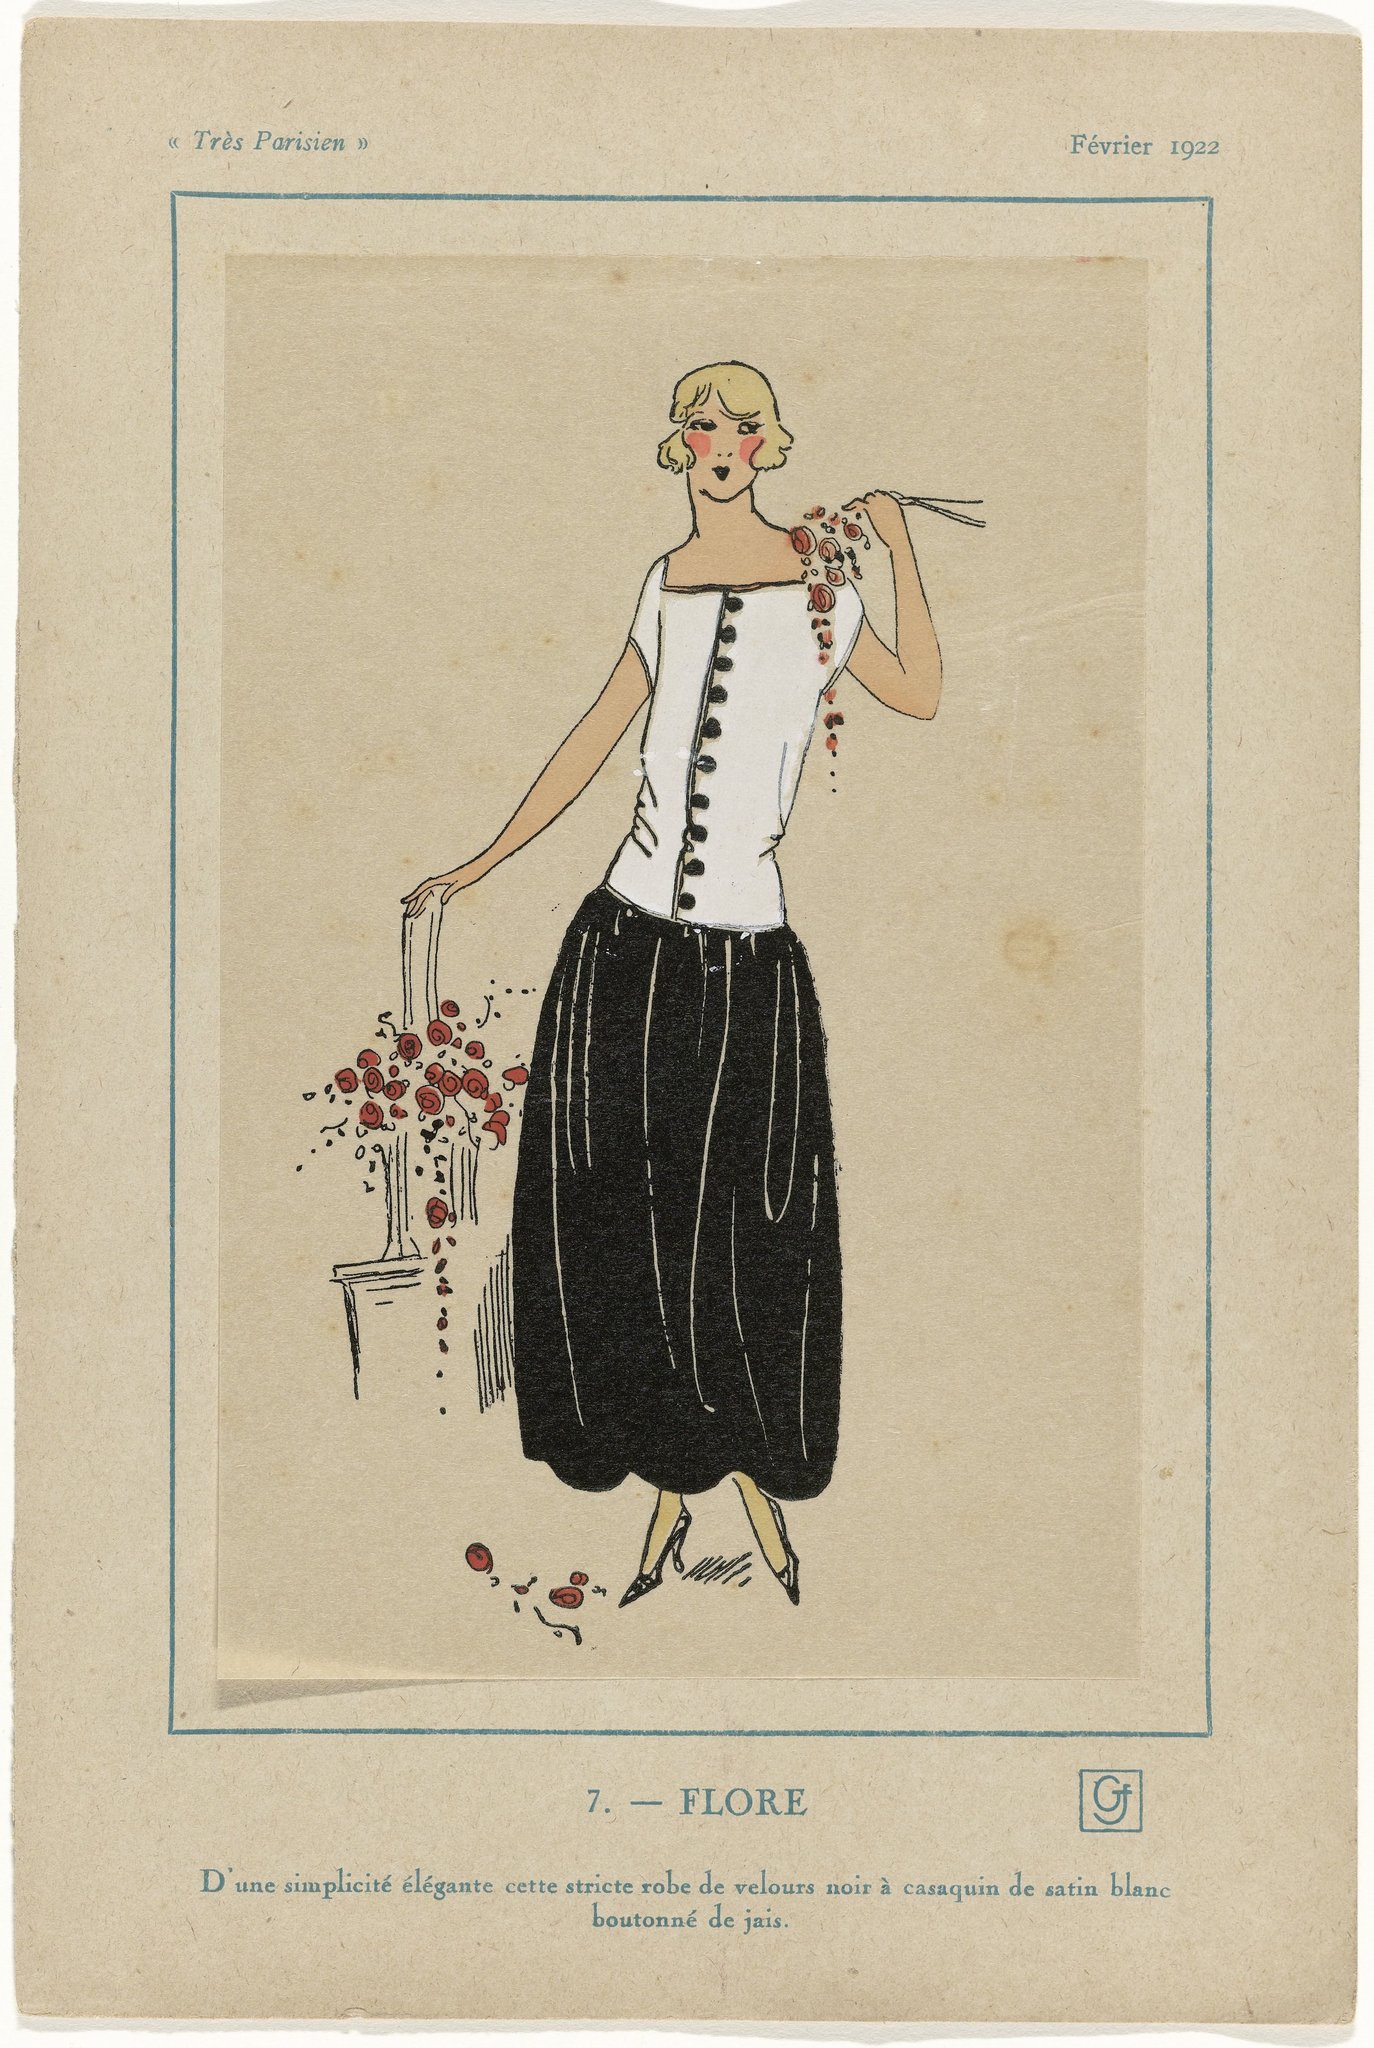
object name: fashion print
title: Très Parisien, février 1922: 7.- FLORE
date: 1922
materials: paper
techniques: hand coloring, letterpress printing, lithography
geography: paris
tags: flowers, clothing for the upper part of the body (+ women's clothes), button (+ women's clothes), fashion plates, dress, gown (+ women's clothes)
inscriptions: caption: ‘7. - FLORE / D'une simplicité élégante cette stricte robe de velours noir à casaquin de satin blanc boutonné de jais.’, title: ‘Très Parisien / Février 1922’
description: Enkellange rok van zwart fluweel waarop een wit satijnen casaquin met knopen van jade. Prent uit het modetijdschrift Très Parisien (1920-1936).